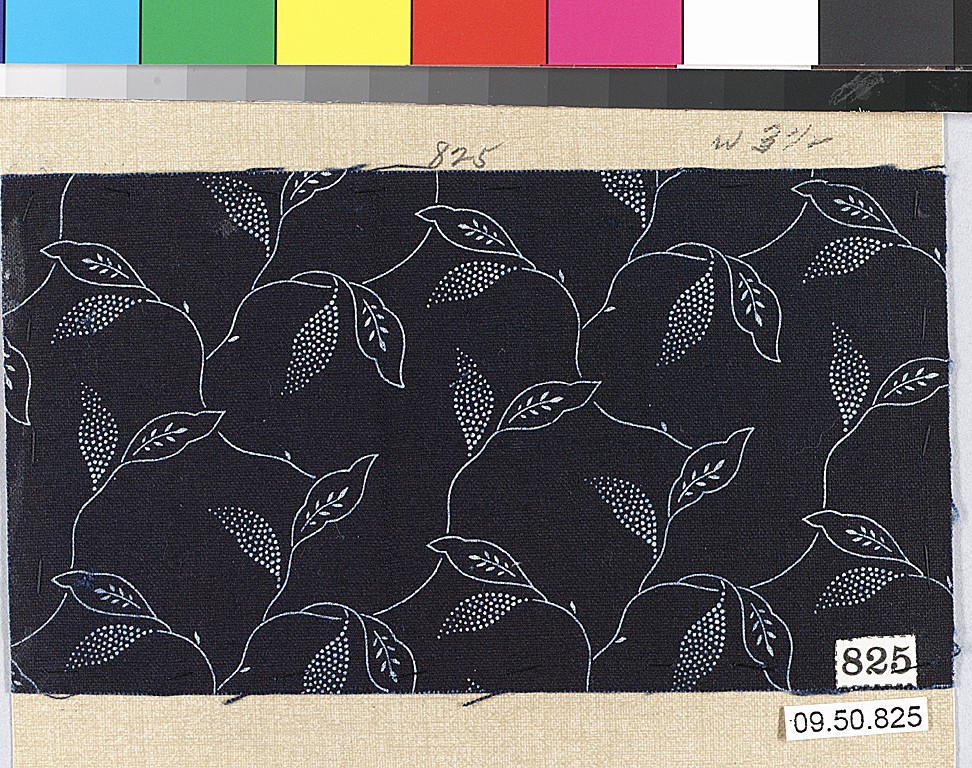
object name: piece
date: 1801-1900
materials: cotton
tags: leaves